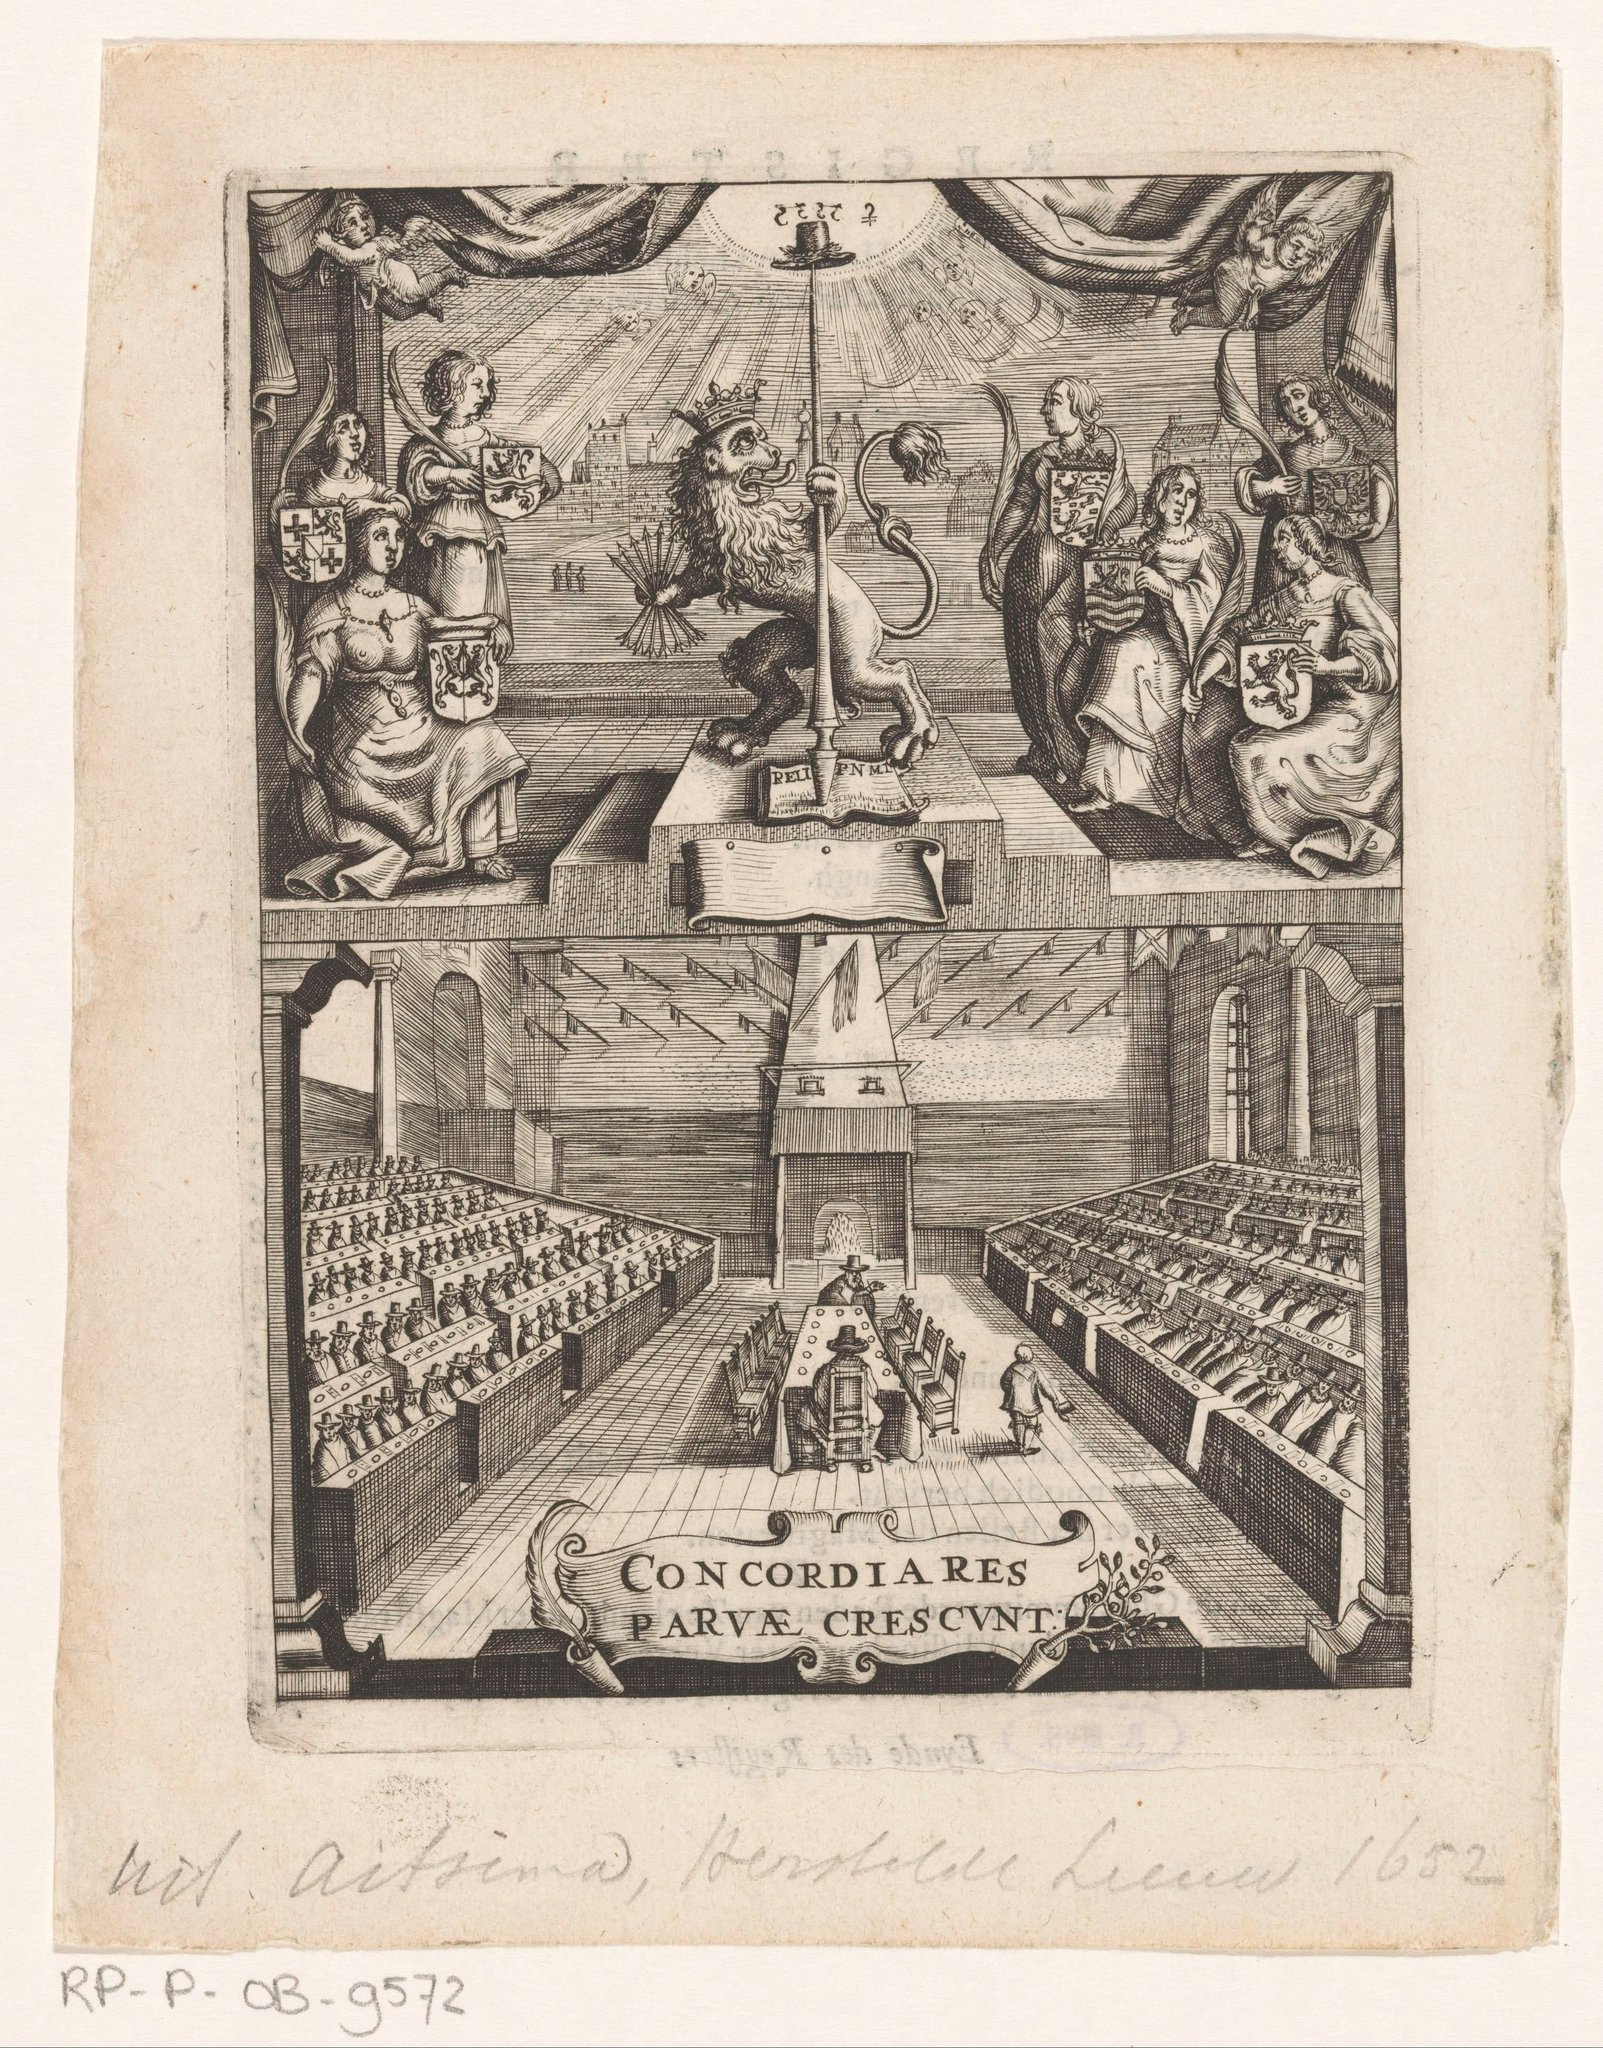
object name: titelblad, titelpagina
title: Hollandse leeuw en Republiek der Zeven Verenigde Nederlanden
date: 1652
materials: paper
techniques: engraving, etching, letterpress printing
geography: the hague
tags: beasts of prey, predatory animals: lion, symbols of particular nations, states, districts, etc., alliance, league, union, foedus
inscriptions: collector's mark: Lugt 2228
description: De Hollandse leeuw met vrijheidshoed en een bundel van zeven pijlen. Rondom staan zeven vrouwen met wapenschilden als personificaties van de zeven staten van de Republiek der Verenigde Nederlanden. Daaronder de zaal waar de Unie van Utrecht werd gesloten.